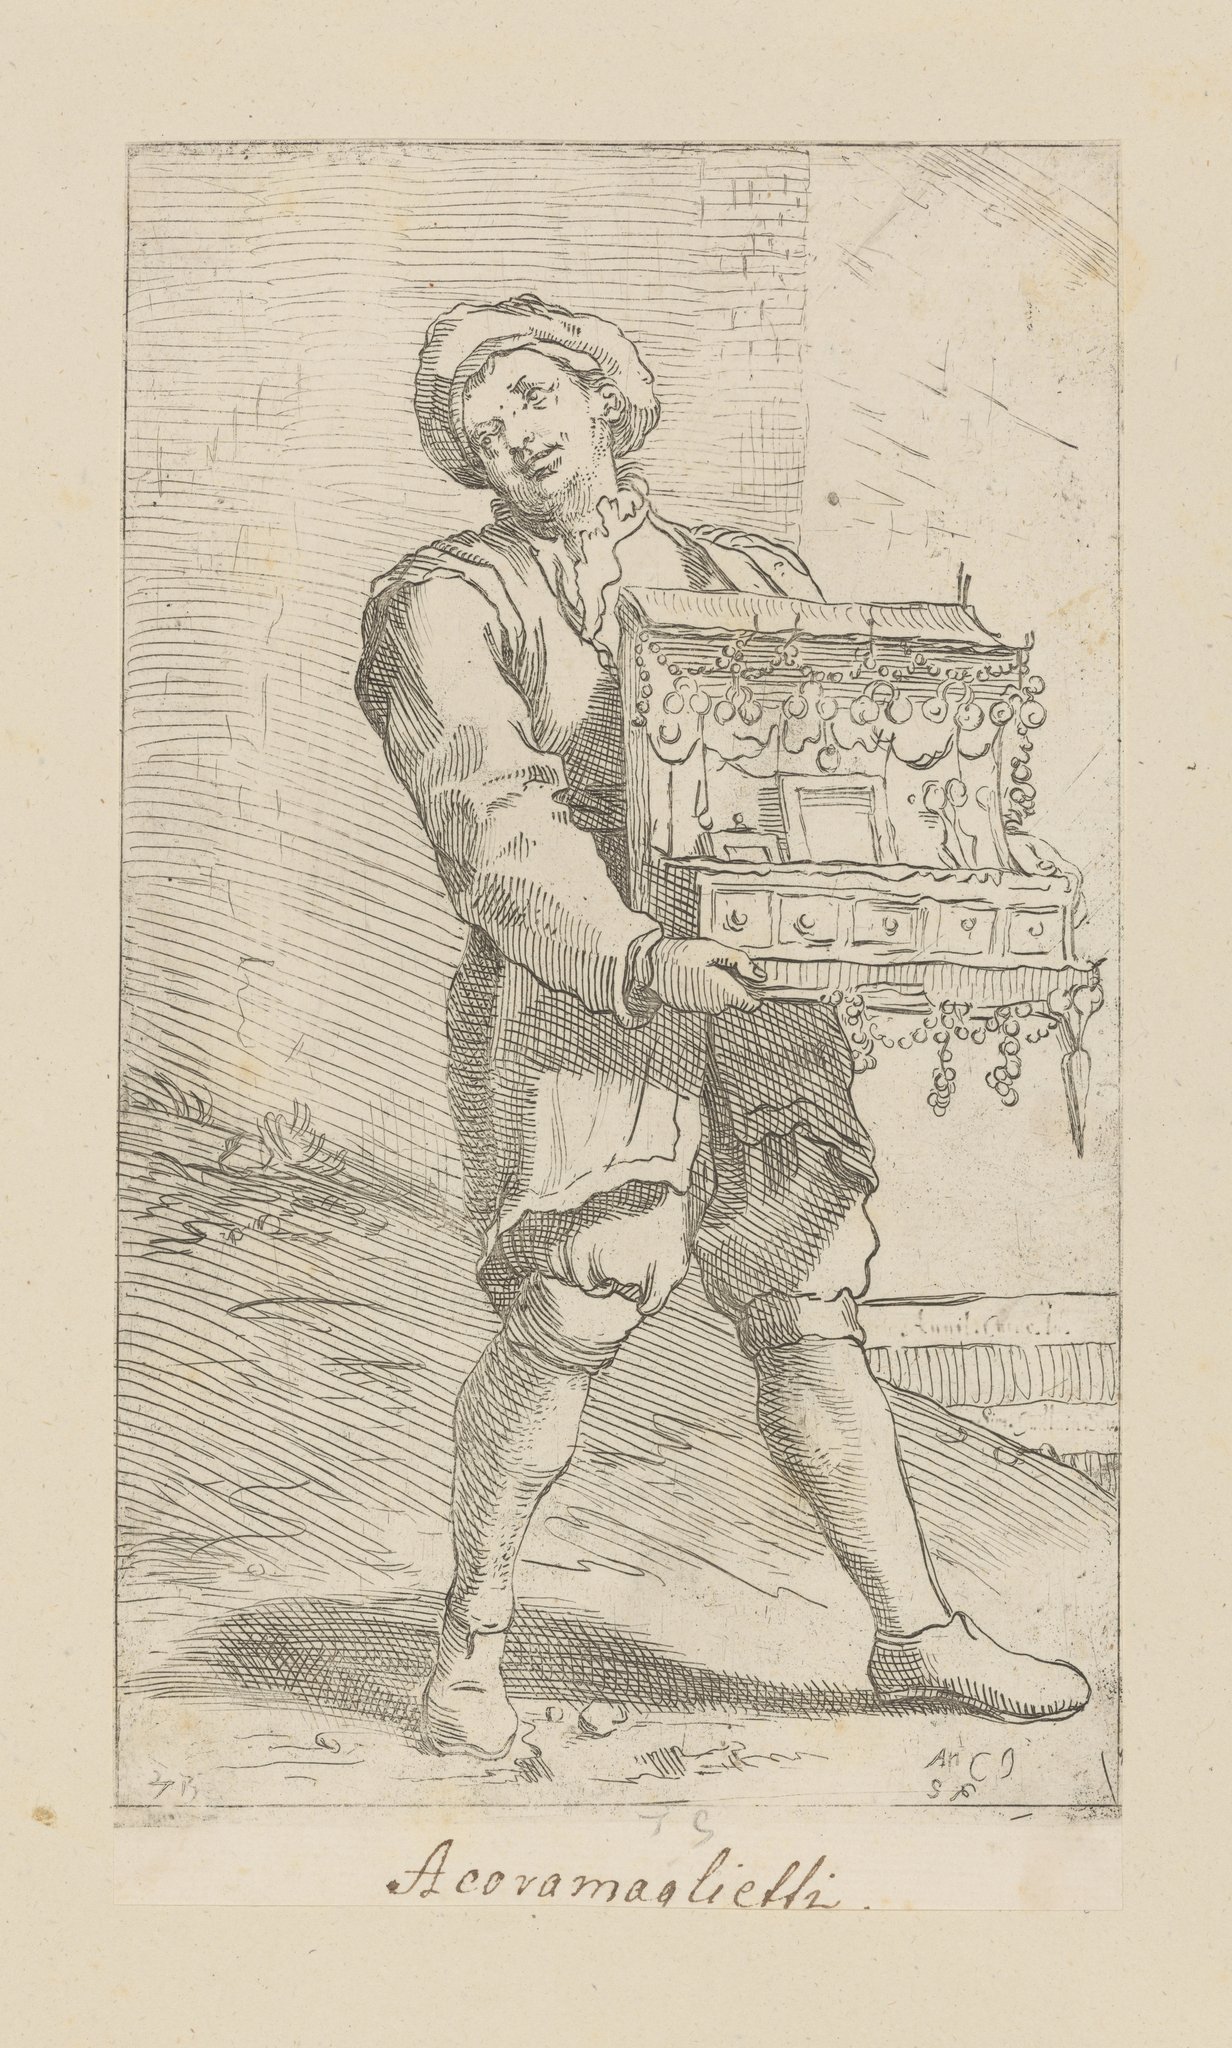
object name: print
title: Plate 71: Trinket vendor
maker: simon guillain ii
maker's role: artist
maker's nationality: french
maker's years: 1618-1718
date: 1646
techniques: etching